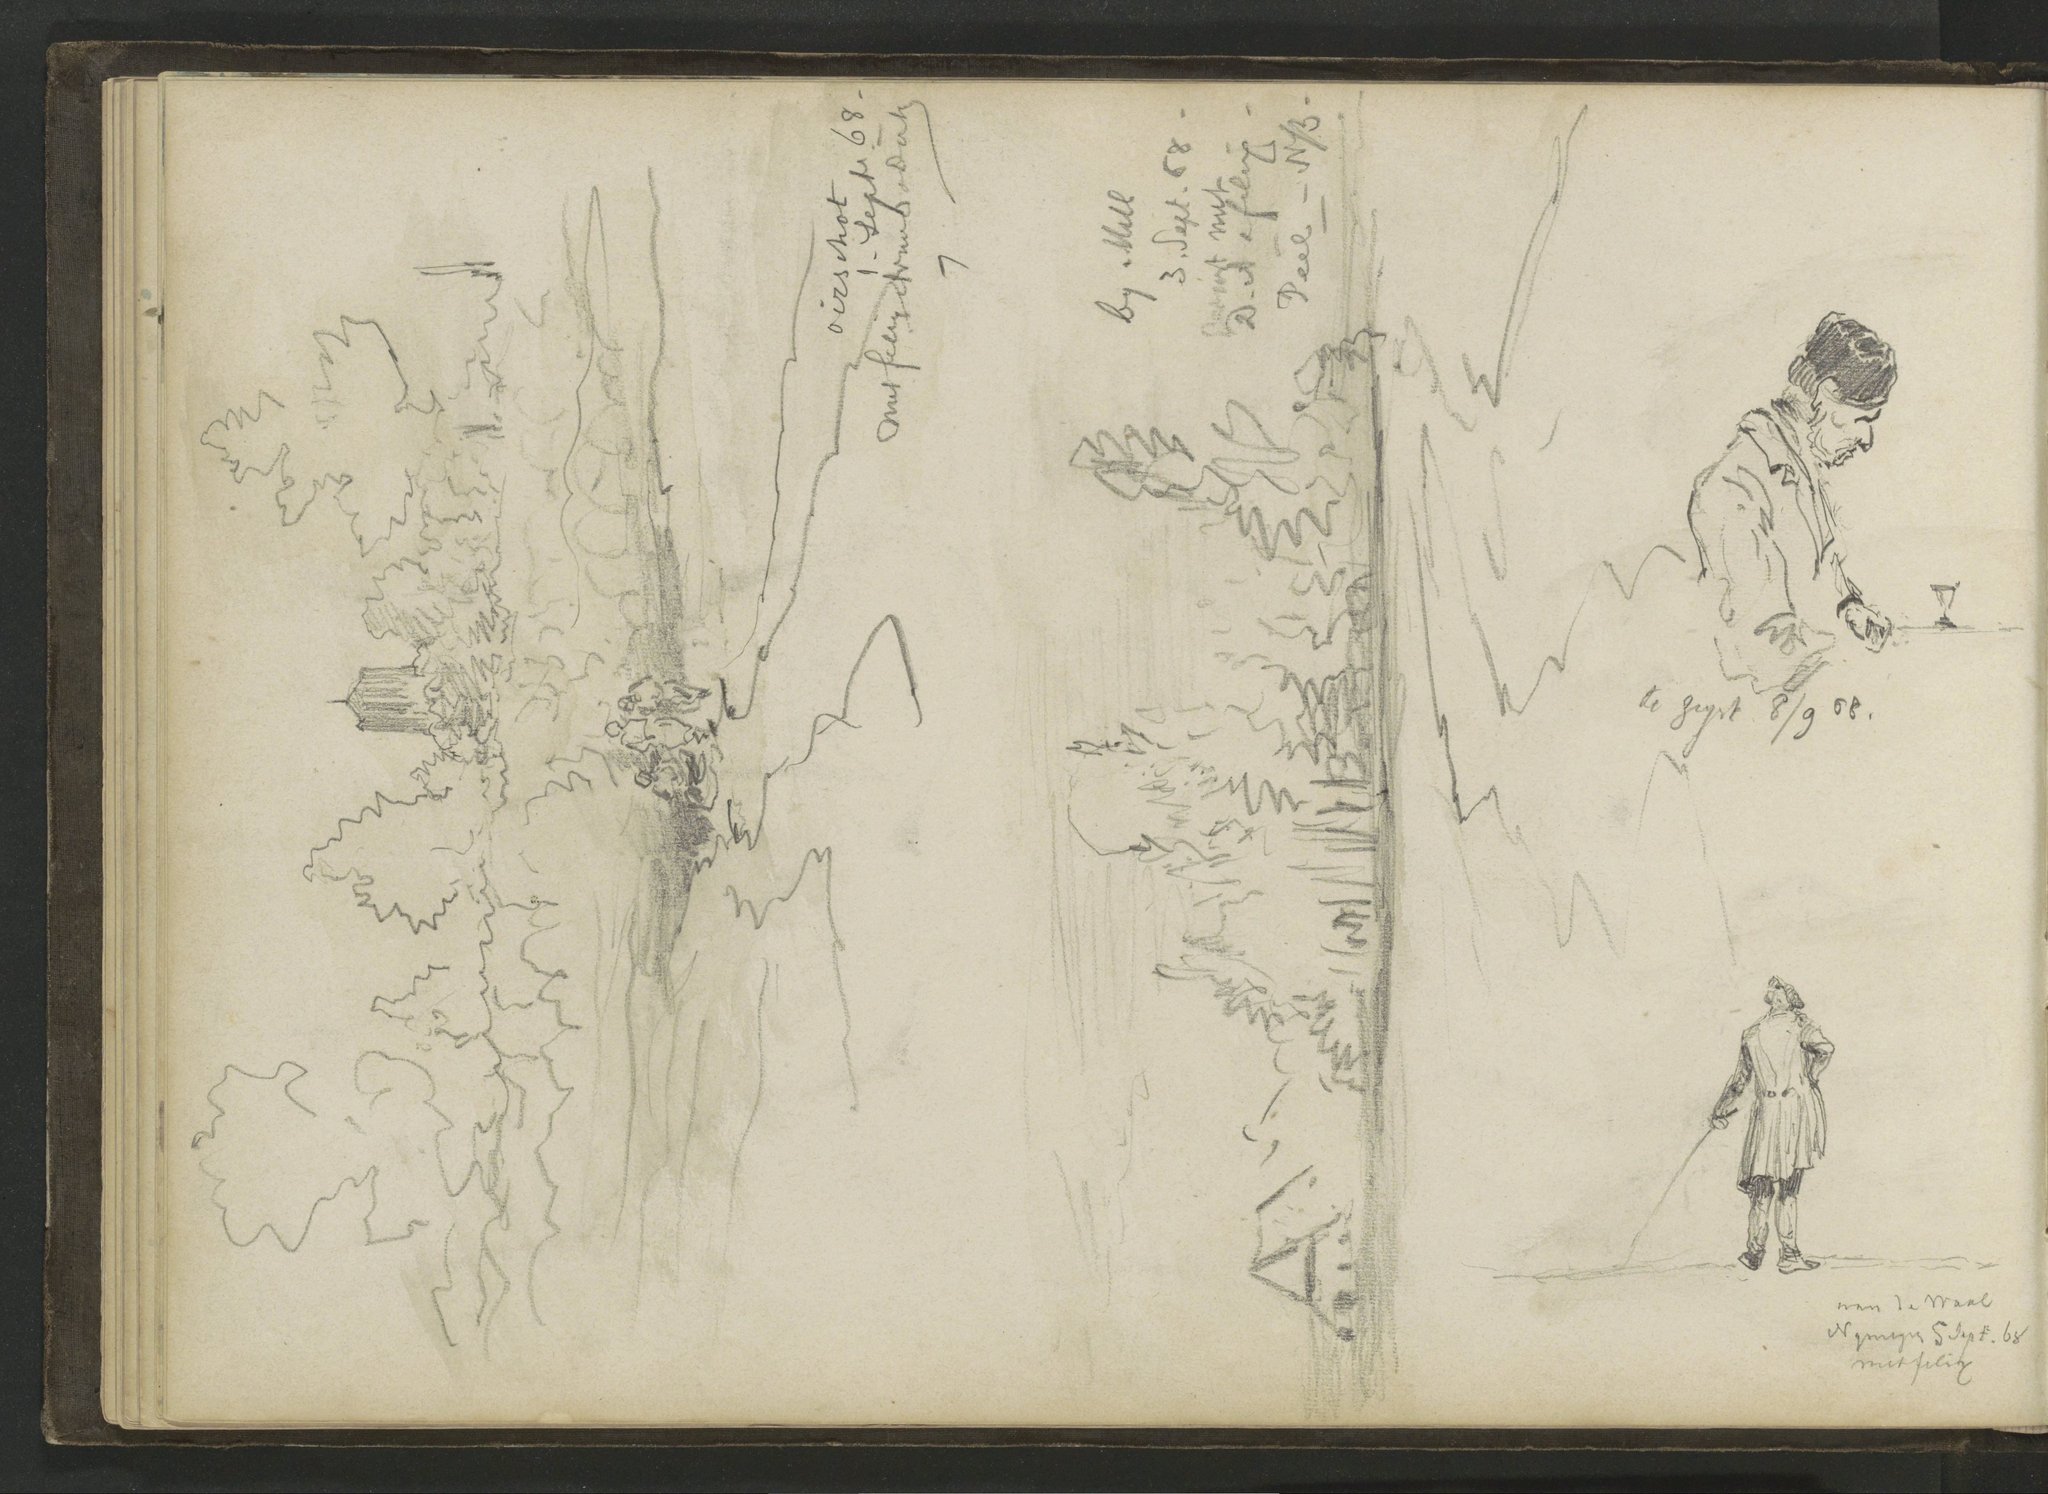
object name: sketchbook leaf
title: Gezicht op Oirschot en de Grote Peel in Noord-Brabant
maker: johannes tavenraat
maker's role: draughtsman, painter, print maker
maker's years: 1809-1881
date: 1809-1868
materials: paper, pencil, watercolor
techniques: brush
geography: grote peel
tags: city-view, and landscape with man-made constructions, adult man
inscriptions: date and inscription: ‘oirschot/ 1 sept 68/ [...]/ bij [...] 3 Sept 68/ gezigt met/ [...] Peel N/B/ van de Waal/ [...] 5 sept 68/ met Felix’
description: Tevens studies van mannen. Blad 34 verso uit een schetsboek met 57 bladen.